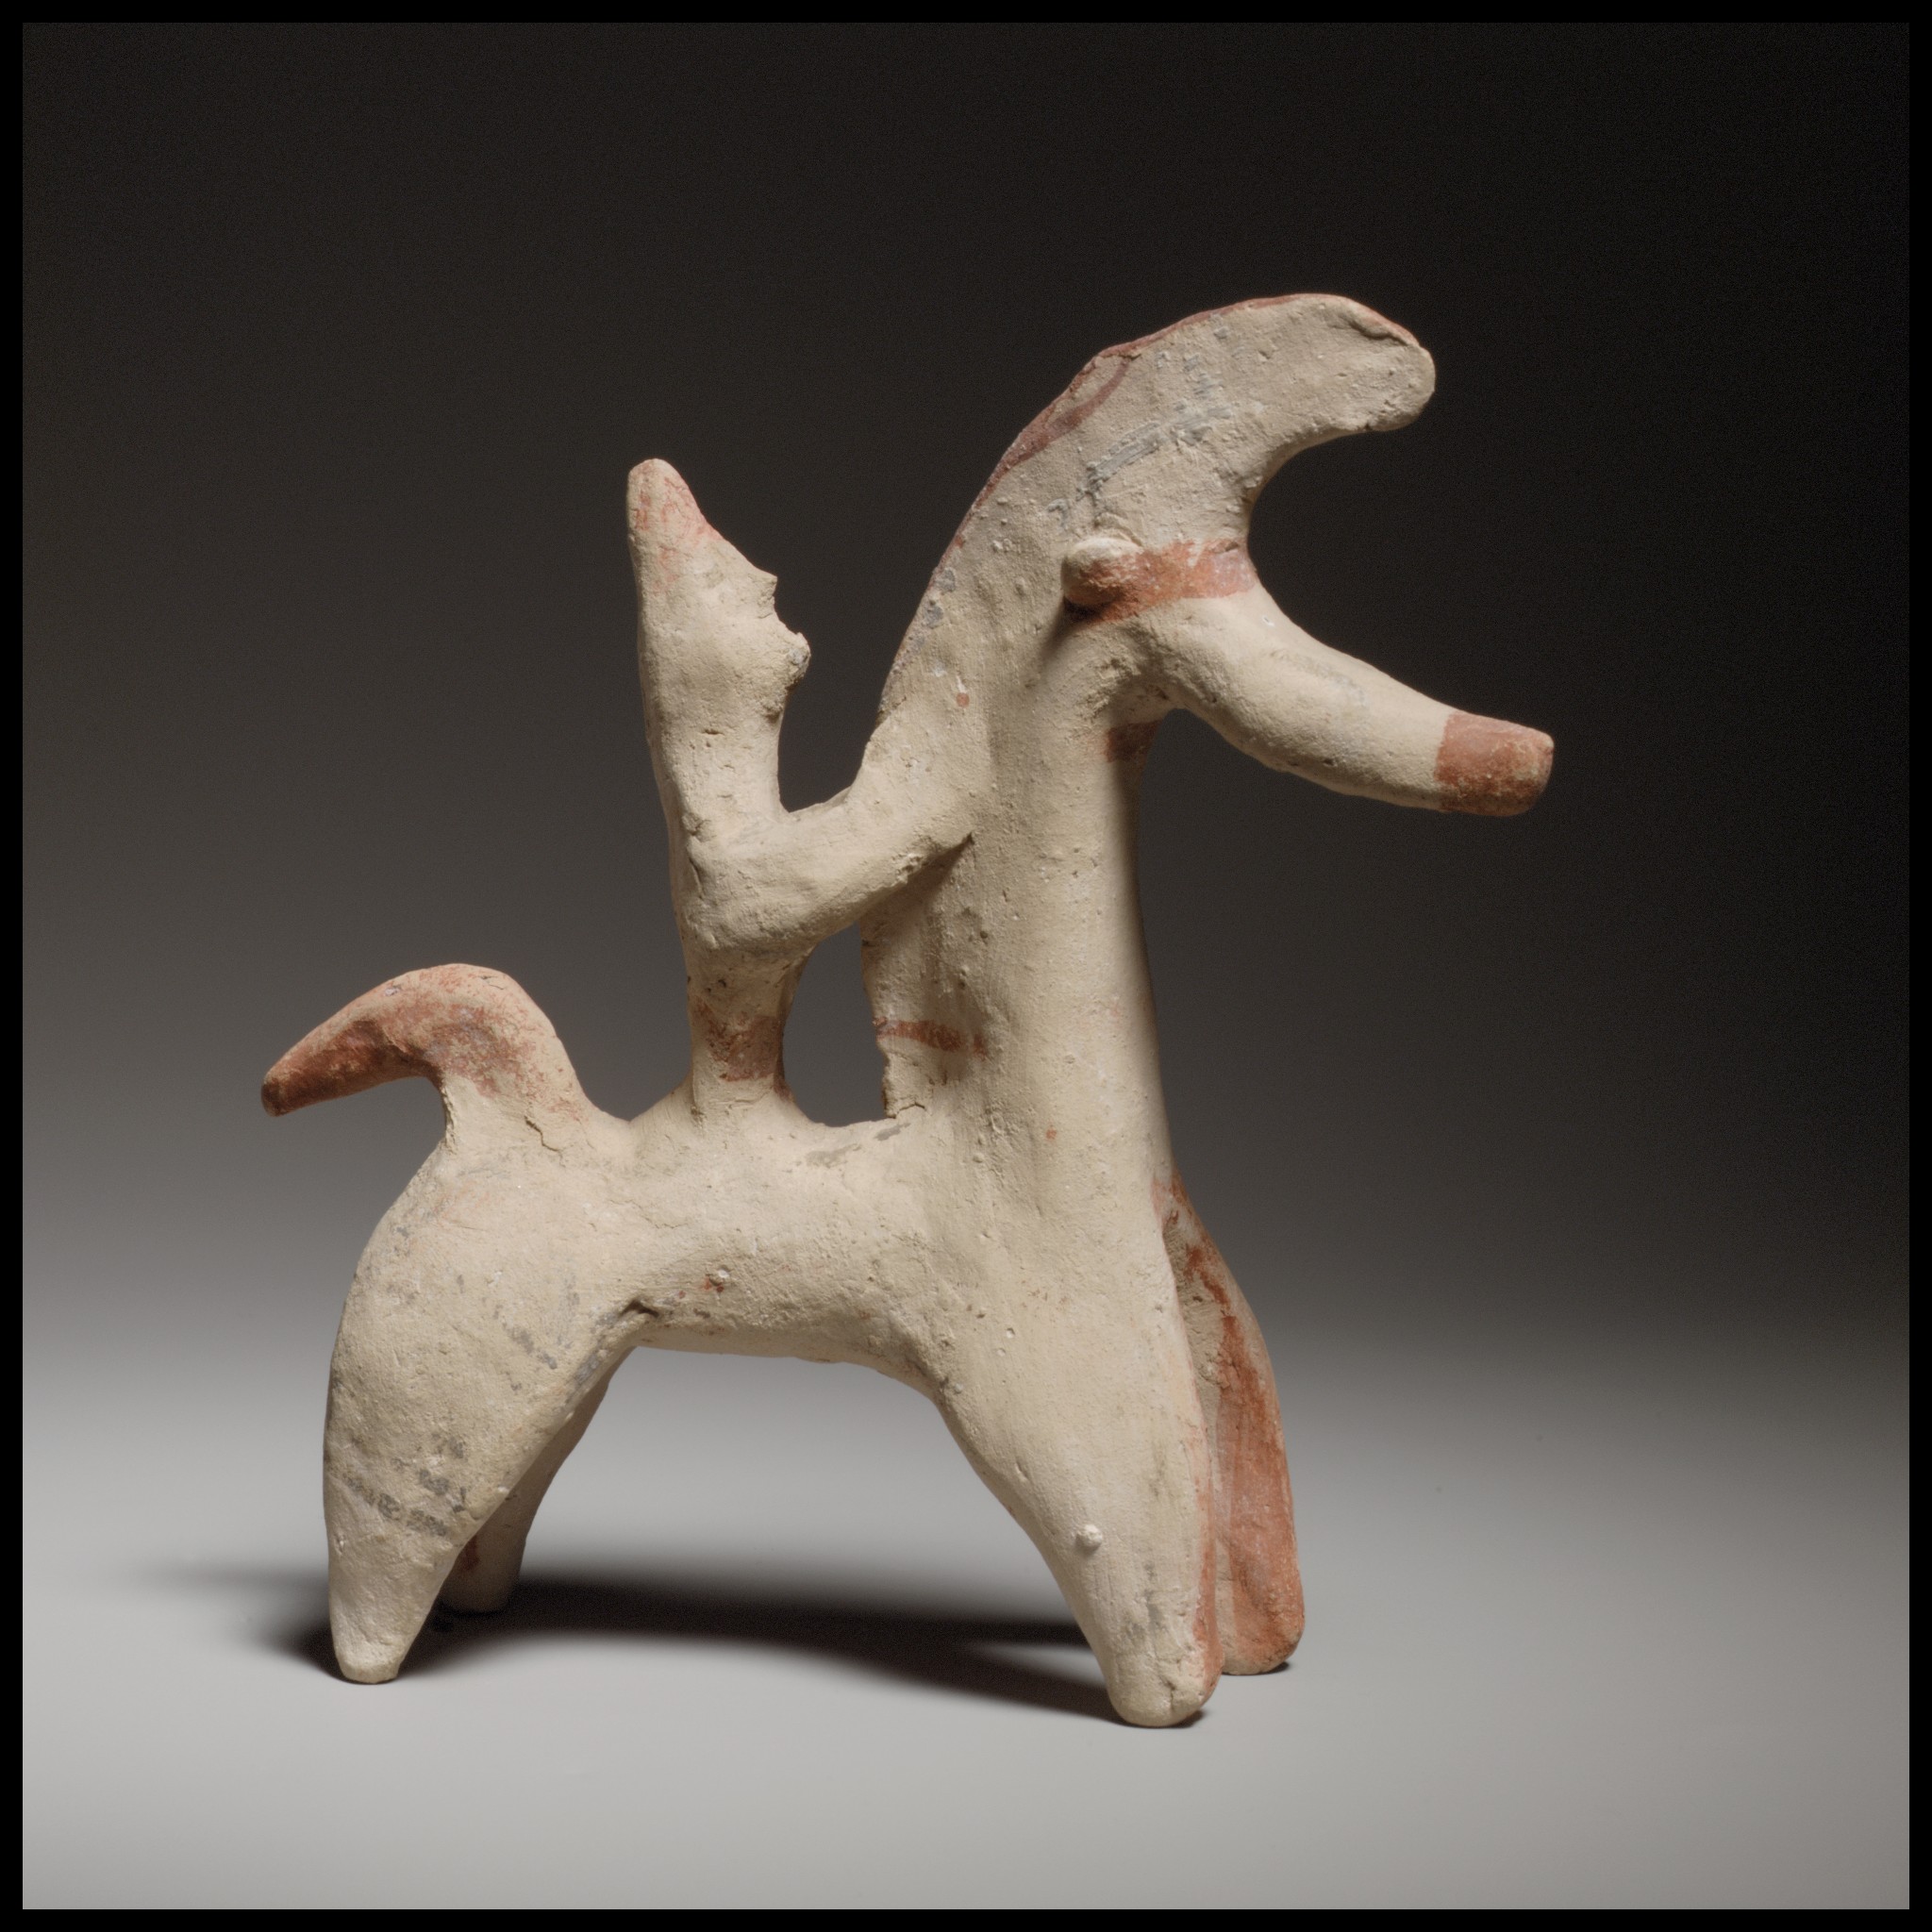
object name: statue of a man on a horse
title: Horse and rider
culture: cypriot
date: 750-600 BCE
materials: terracotta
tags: human figures,horses